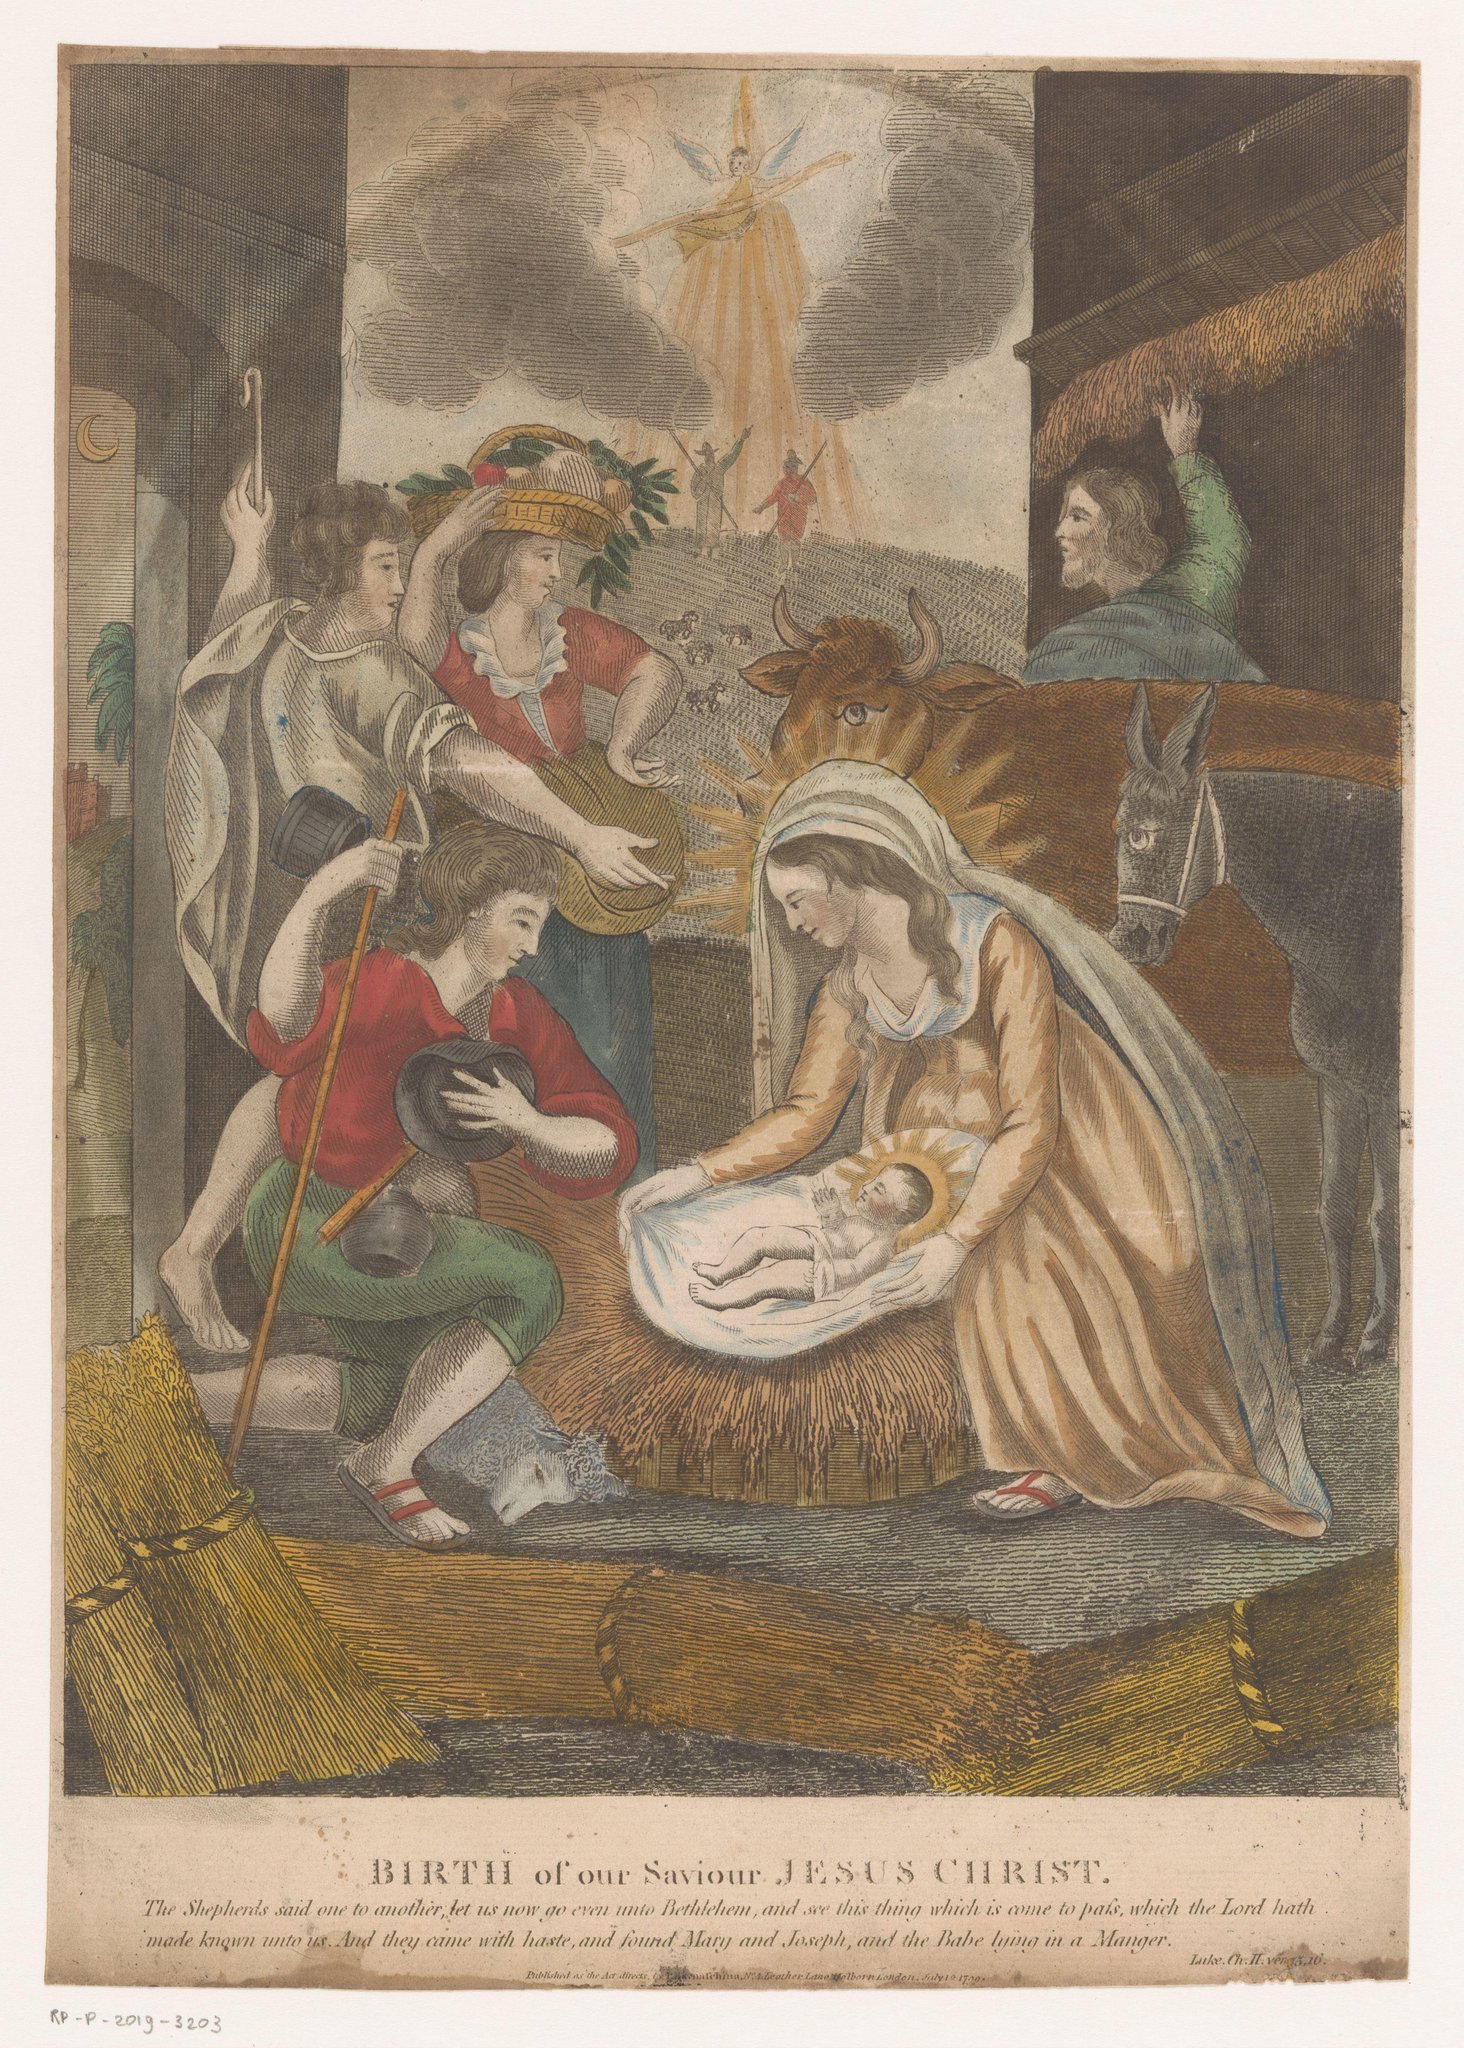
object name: print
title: Aanbidding der herders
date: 1799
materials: paper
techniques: etching, hand coloring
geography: london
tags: adoration of the christ-child by the shepherds; mary and joseph present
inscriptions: collector's mark: Lugt 2228, : ‘Published as the act directs [...]schina, No. 4 Leather Lane Holborn London, July 12 1799.’